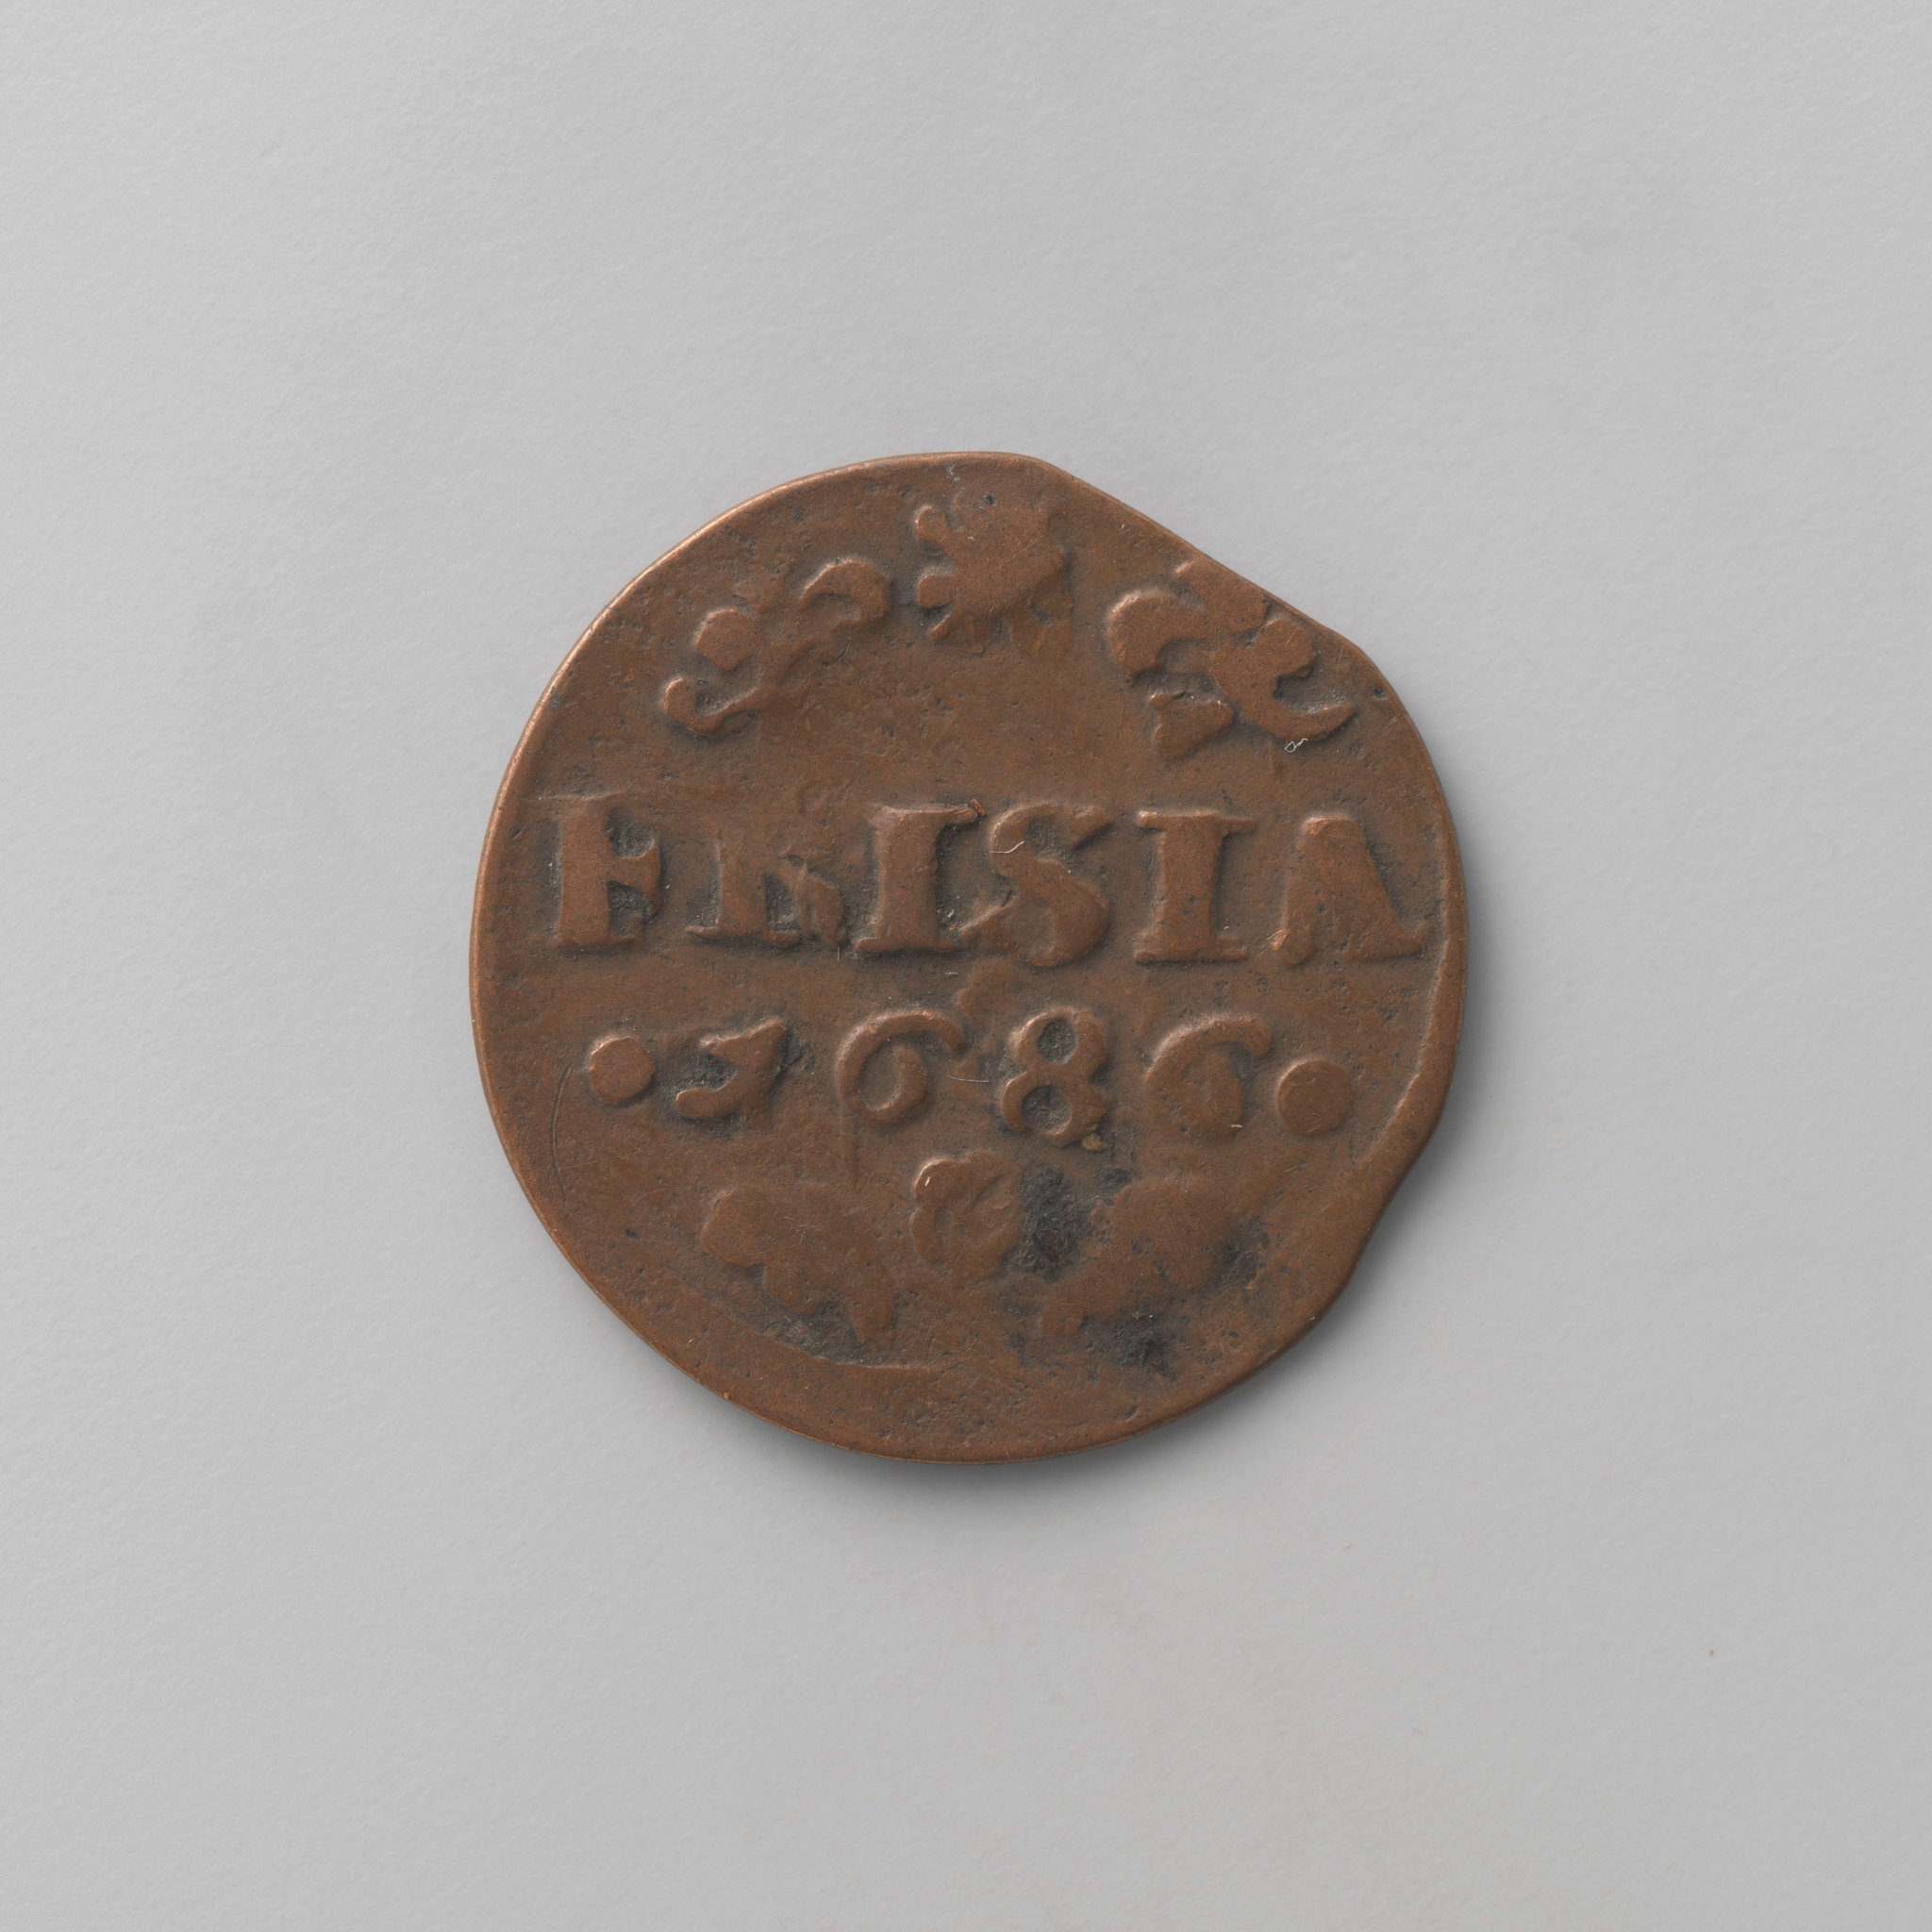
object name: coin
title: Duit van Friesland, 1686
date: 1686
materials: copper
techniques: striking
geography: leeuwarden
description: Koperen munt. Voorzijde: gekroond en versierd wapenschild van Friesland. Keerzijde: muntteken tussen guirlandes, daaronder opschrift in een regel, waaronder jaartal. Daaronder rozet tussen twee guirlandes.